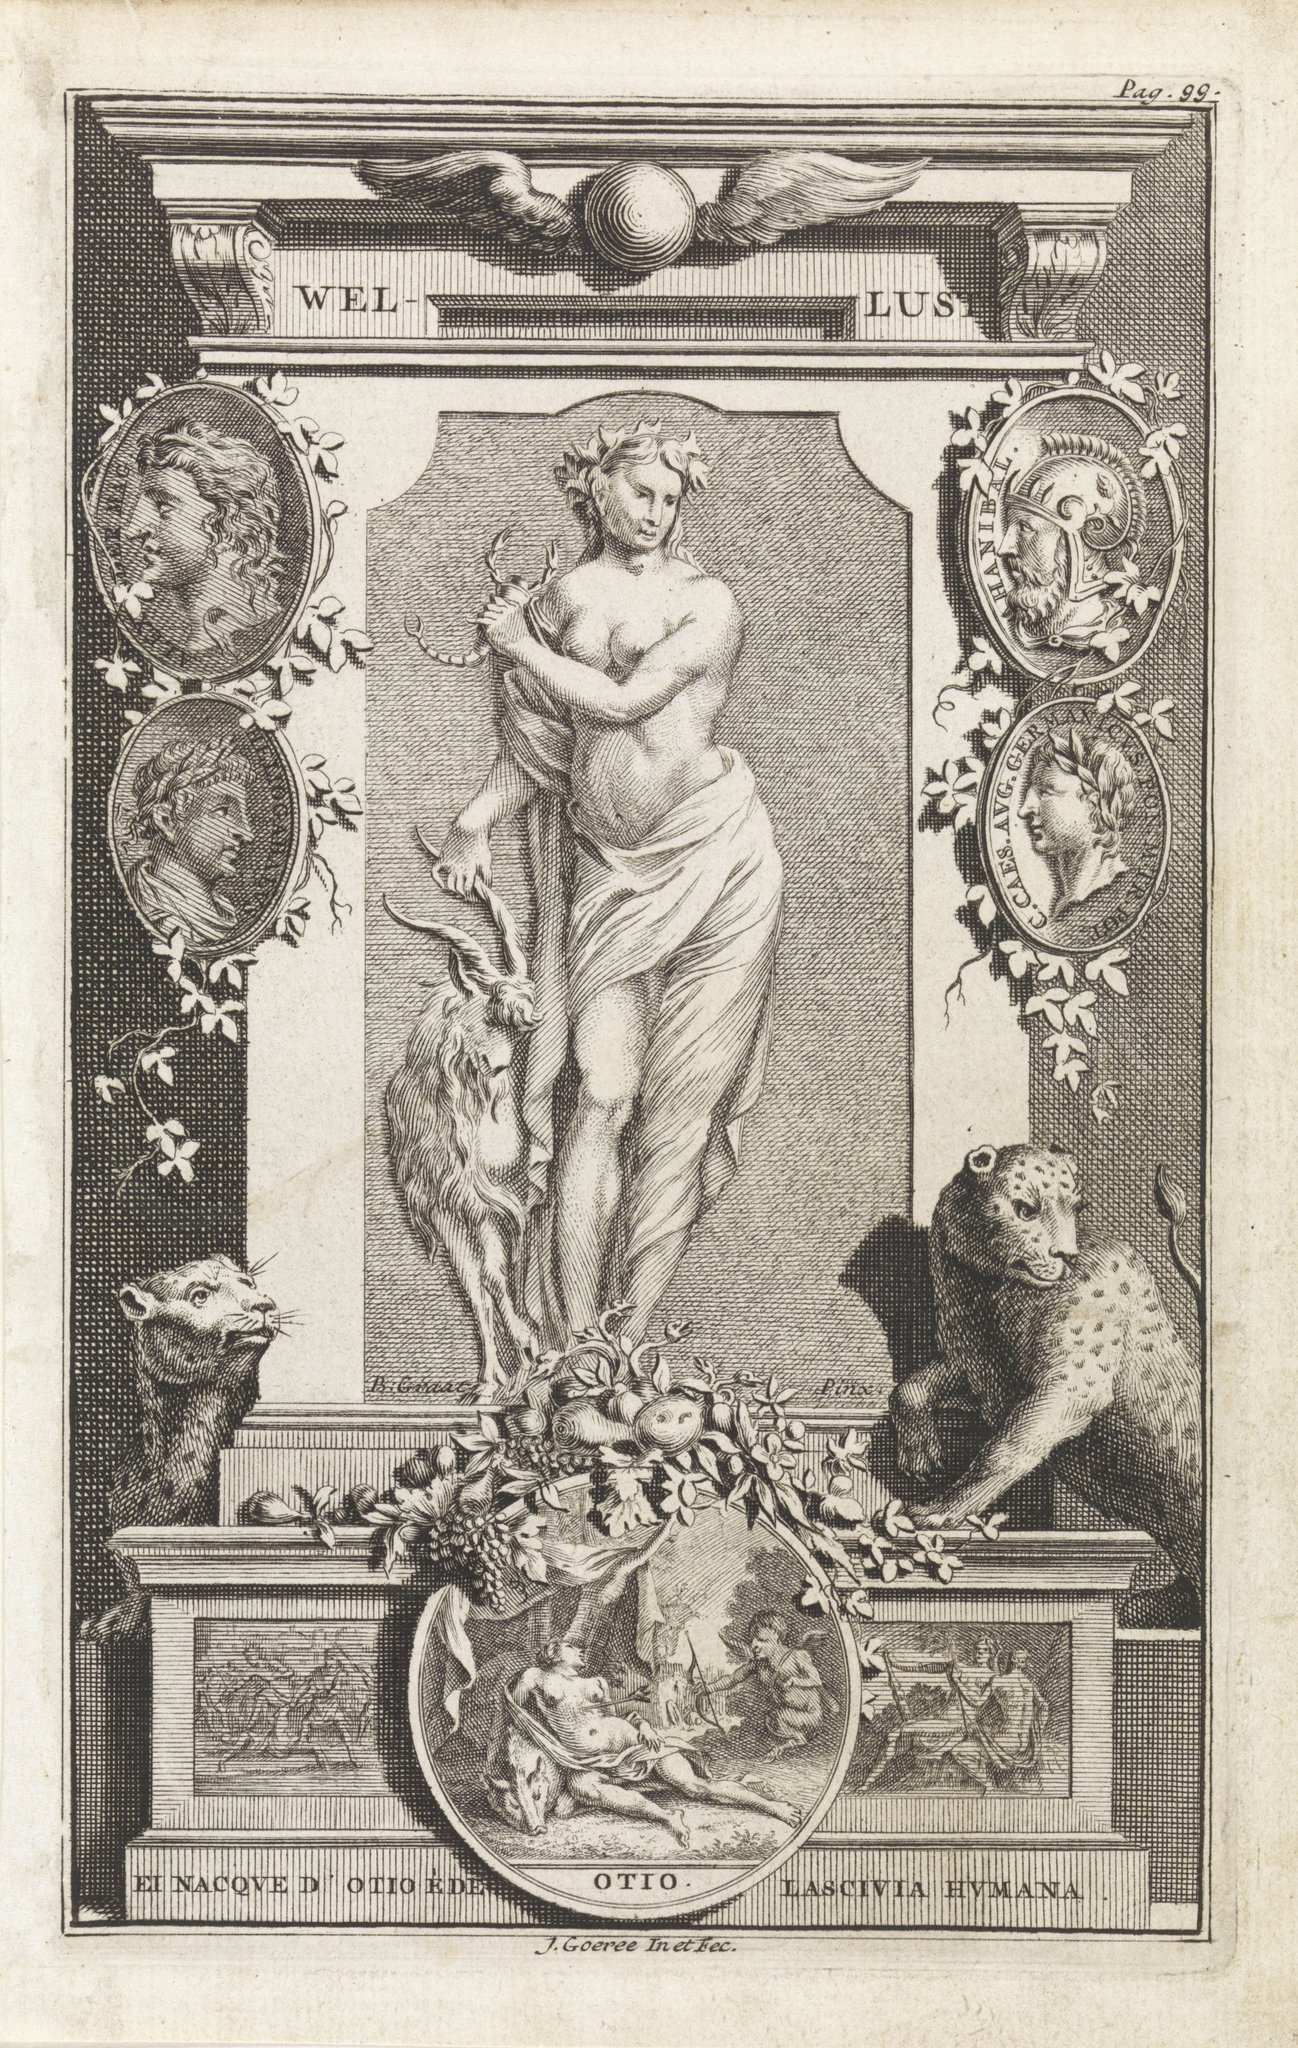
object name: book illustration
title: Wel-lust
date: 1710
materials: paper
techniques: engraving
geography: amsterdam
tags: beasts of prey, predatory animals: leopard, cupid shooting a dart, lust, luxury, 'luxuria'; 'lussuria' (ripa) ~ personification of one of the deadly sins, (story of) alexander the great, (story of) germanicus, (story of) hannibal, male persons from classical history (elegabalus)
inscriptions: collector's mark: Lugt 2228, collector's mark: Lugt 2760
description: De personificatie Wellust. In haar hand een schorpioen. Naast haar een bok. Wellust staat op een ornamenteel podium met onder een medaillon met een voorstelling van Cupido die een pijl afschiet naar een vrouw en een wild zwijn. Aan weerszijden van het podium ovalen met portretten van klassieke figuren: Alexander de Grote, Elegabalus, Hannibal en Germanicus. Twee luipaarden beklimmen het podium. De prent heeft een Latijns onderschrift.